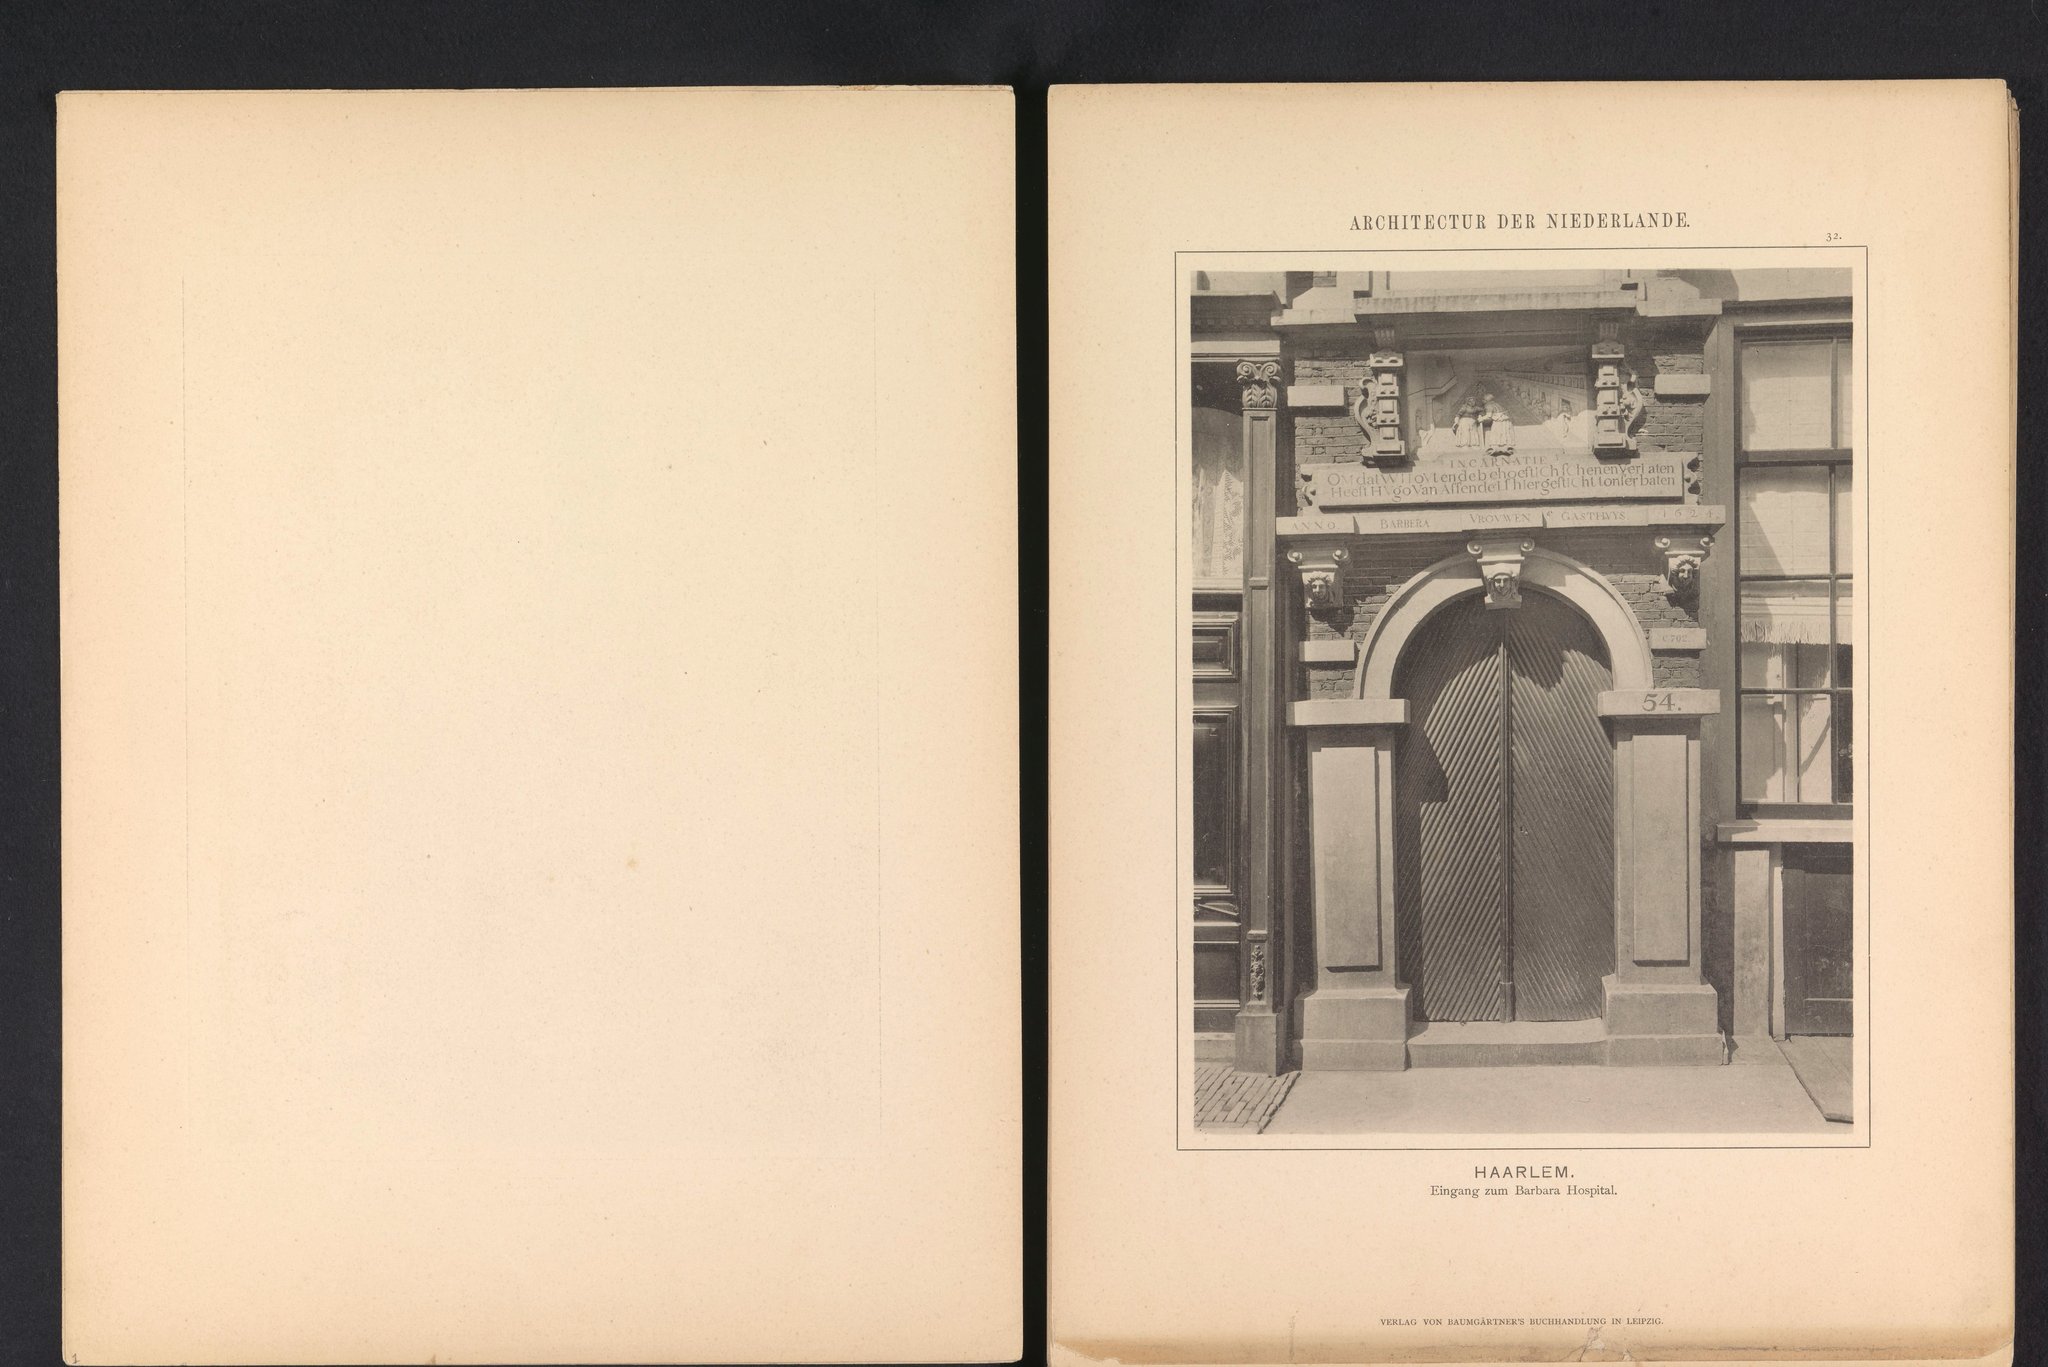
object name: photomechanical print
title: Gezicht op de poort van het Barbera vrouwengasthuis in Haarlem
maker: Anonymous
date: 1884-1894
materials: paper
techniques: photograph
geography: leipzig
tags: gate, entrance, hospital, haarlem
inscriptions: number: ‘32.’